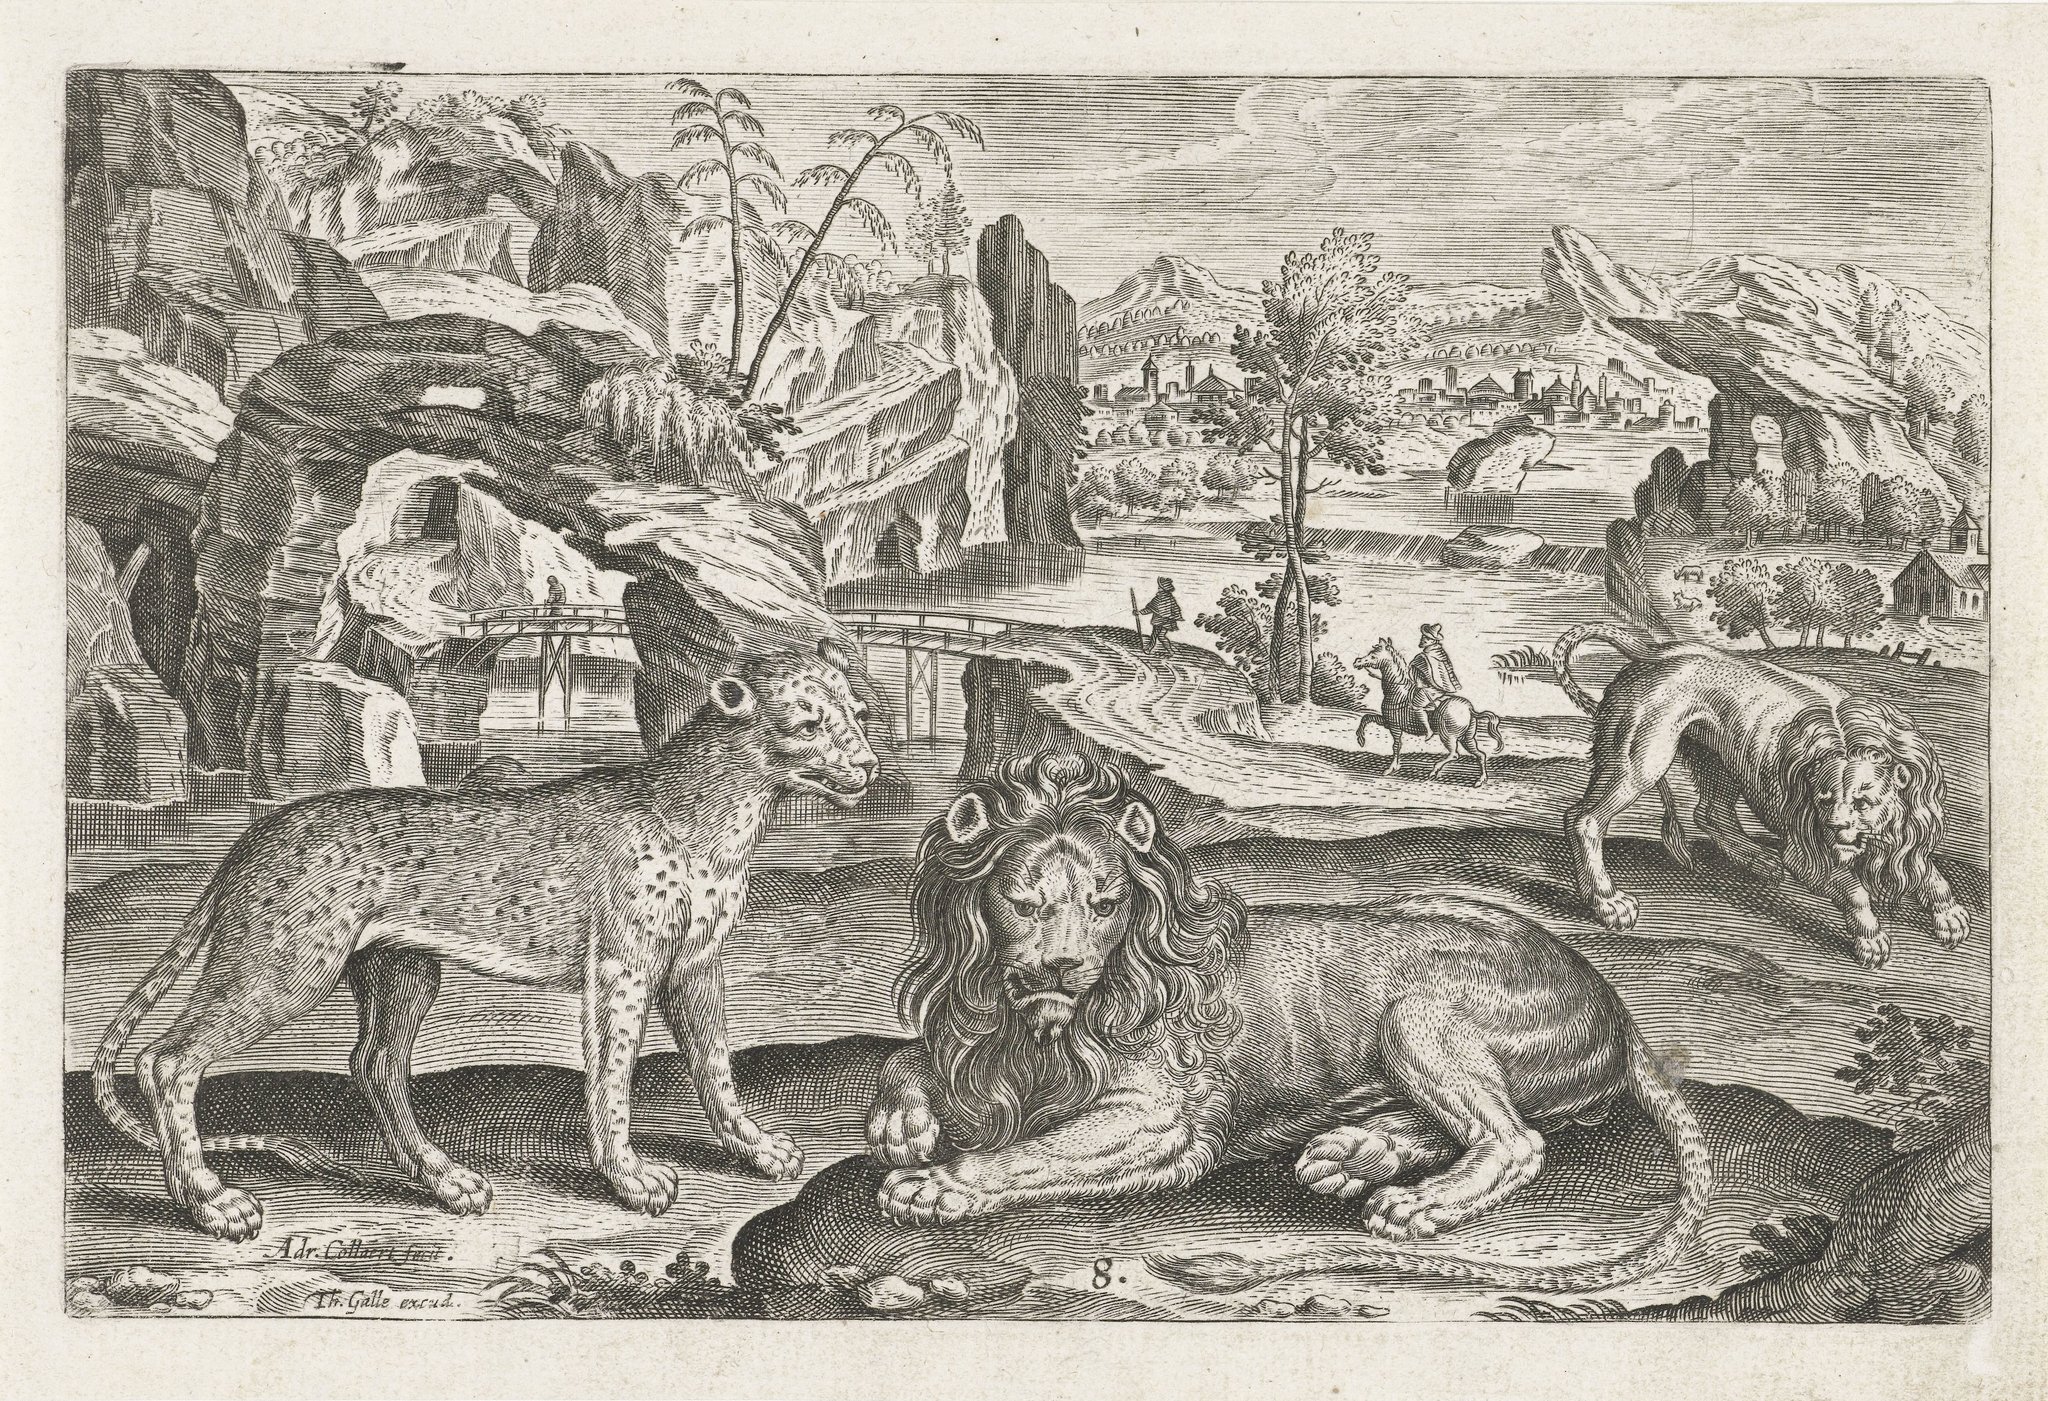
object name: print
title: Leeuwen en luipaard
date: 1595-1633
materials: paper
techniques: engraving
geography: amsterdam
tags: beasts of prey, predatory animals: leopard, river, beasts of prey, predatory animals: lion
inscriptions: collector's mark: Lugt 2228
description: Twee leeuwen en een luipaard op de voorgrond. Op de achtergrond een landschap met een rivier. De prent maakt deel uit van een serie met dieren als onderwerp.